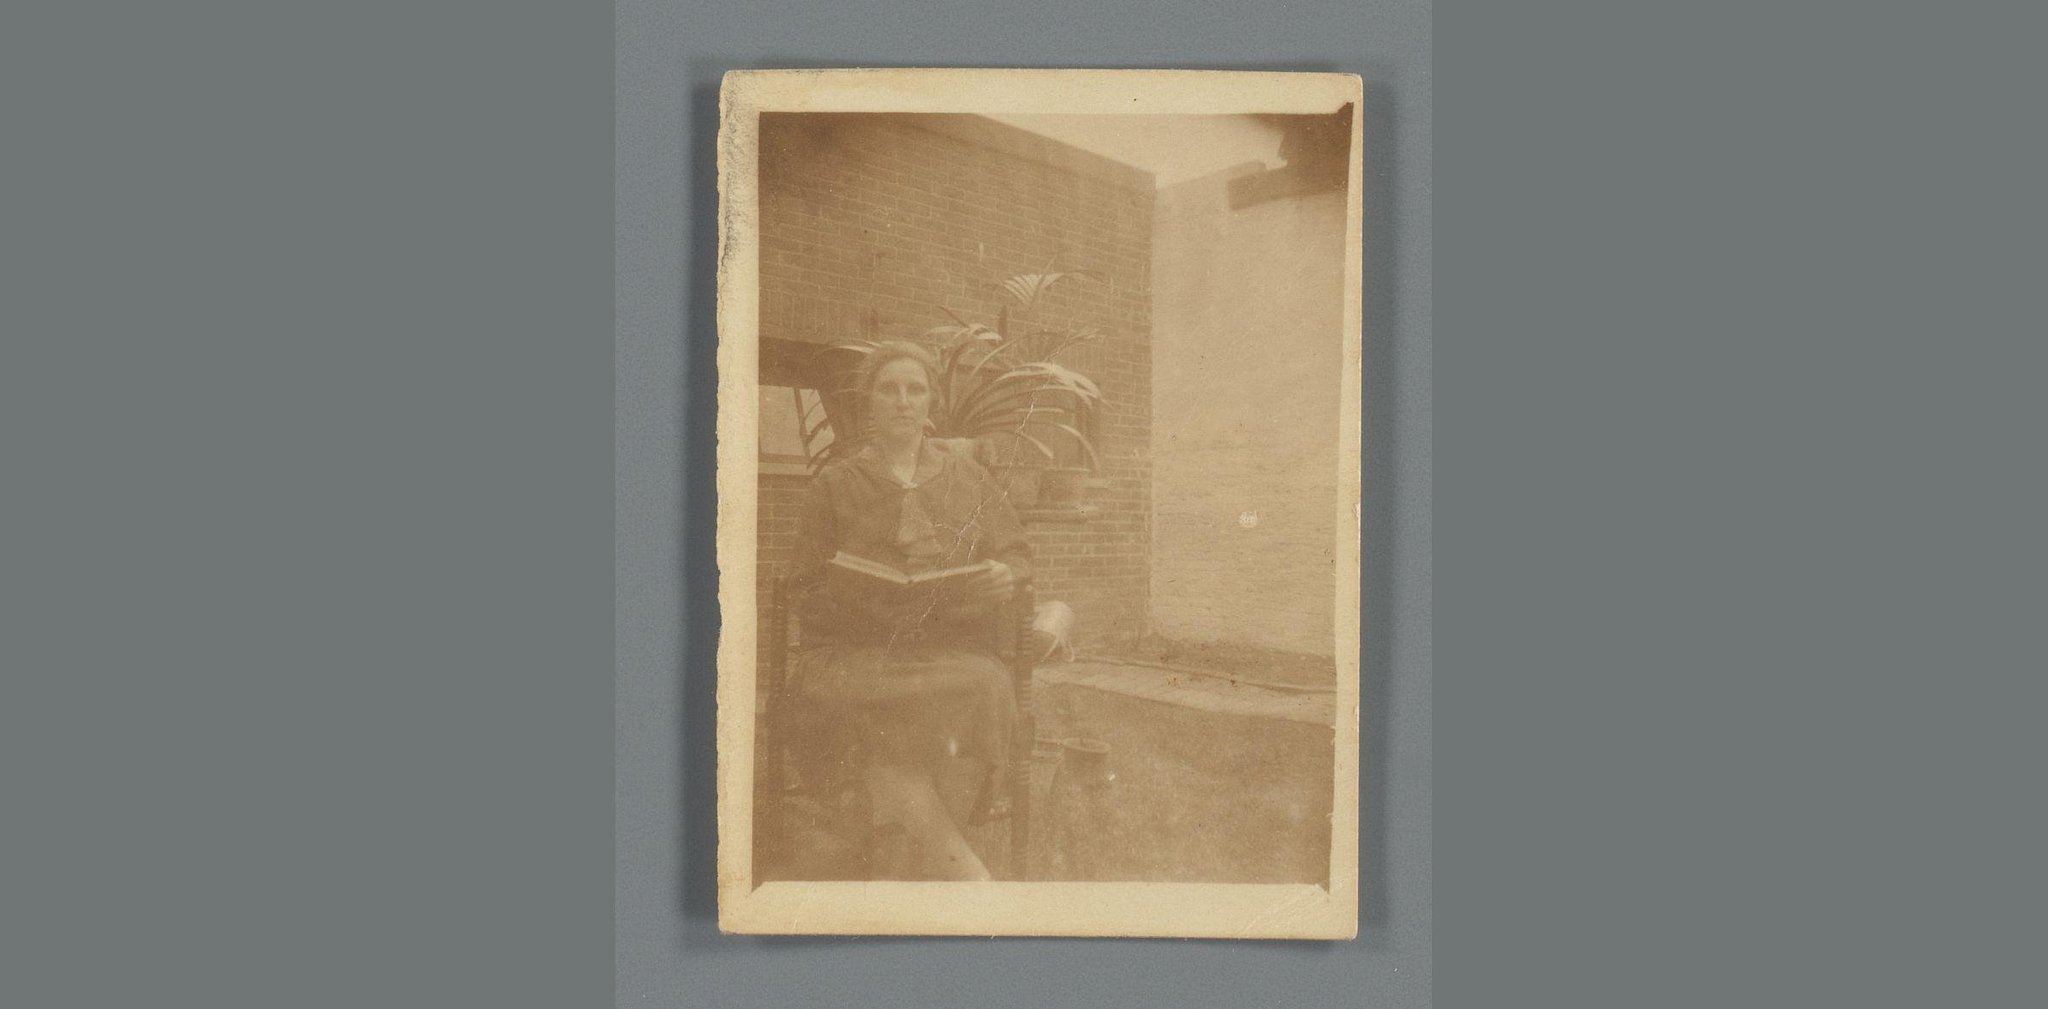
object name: photograph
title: Portret van een onbekende vrouw lezend in een tuin of op een balkon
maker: Anonymous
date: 1910-1930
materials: paper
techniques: gelatin silver print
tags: reading, historical persons not known by name - bb - woman